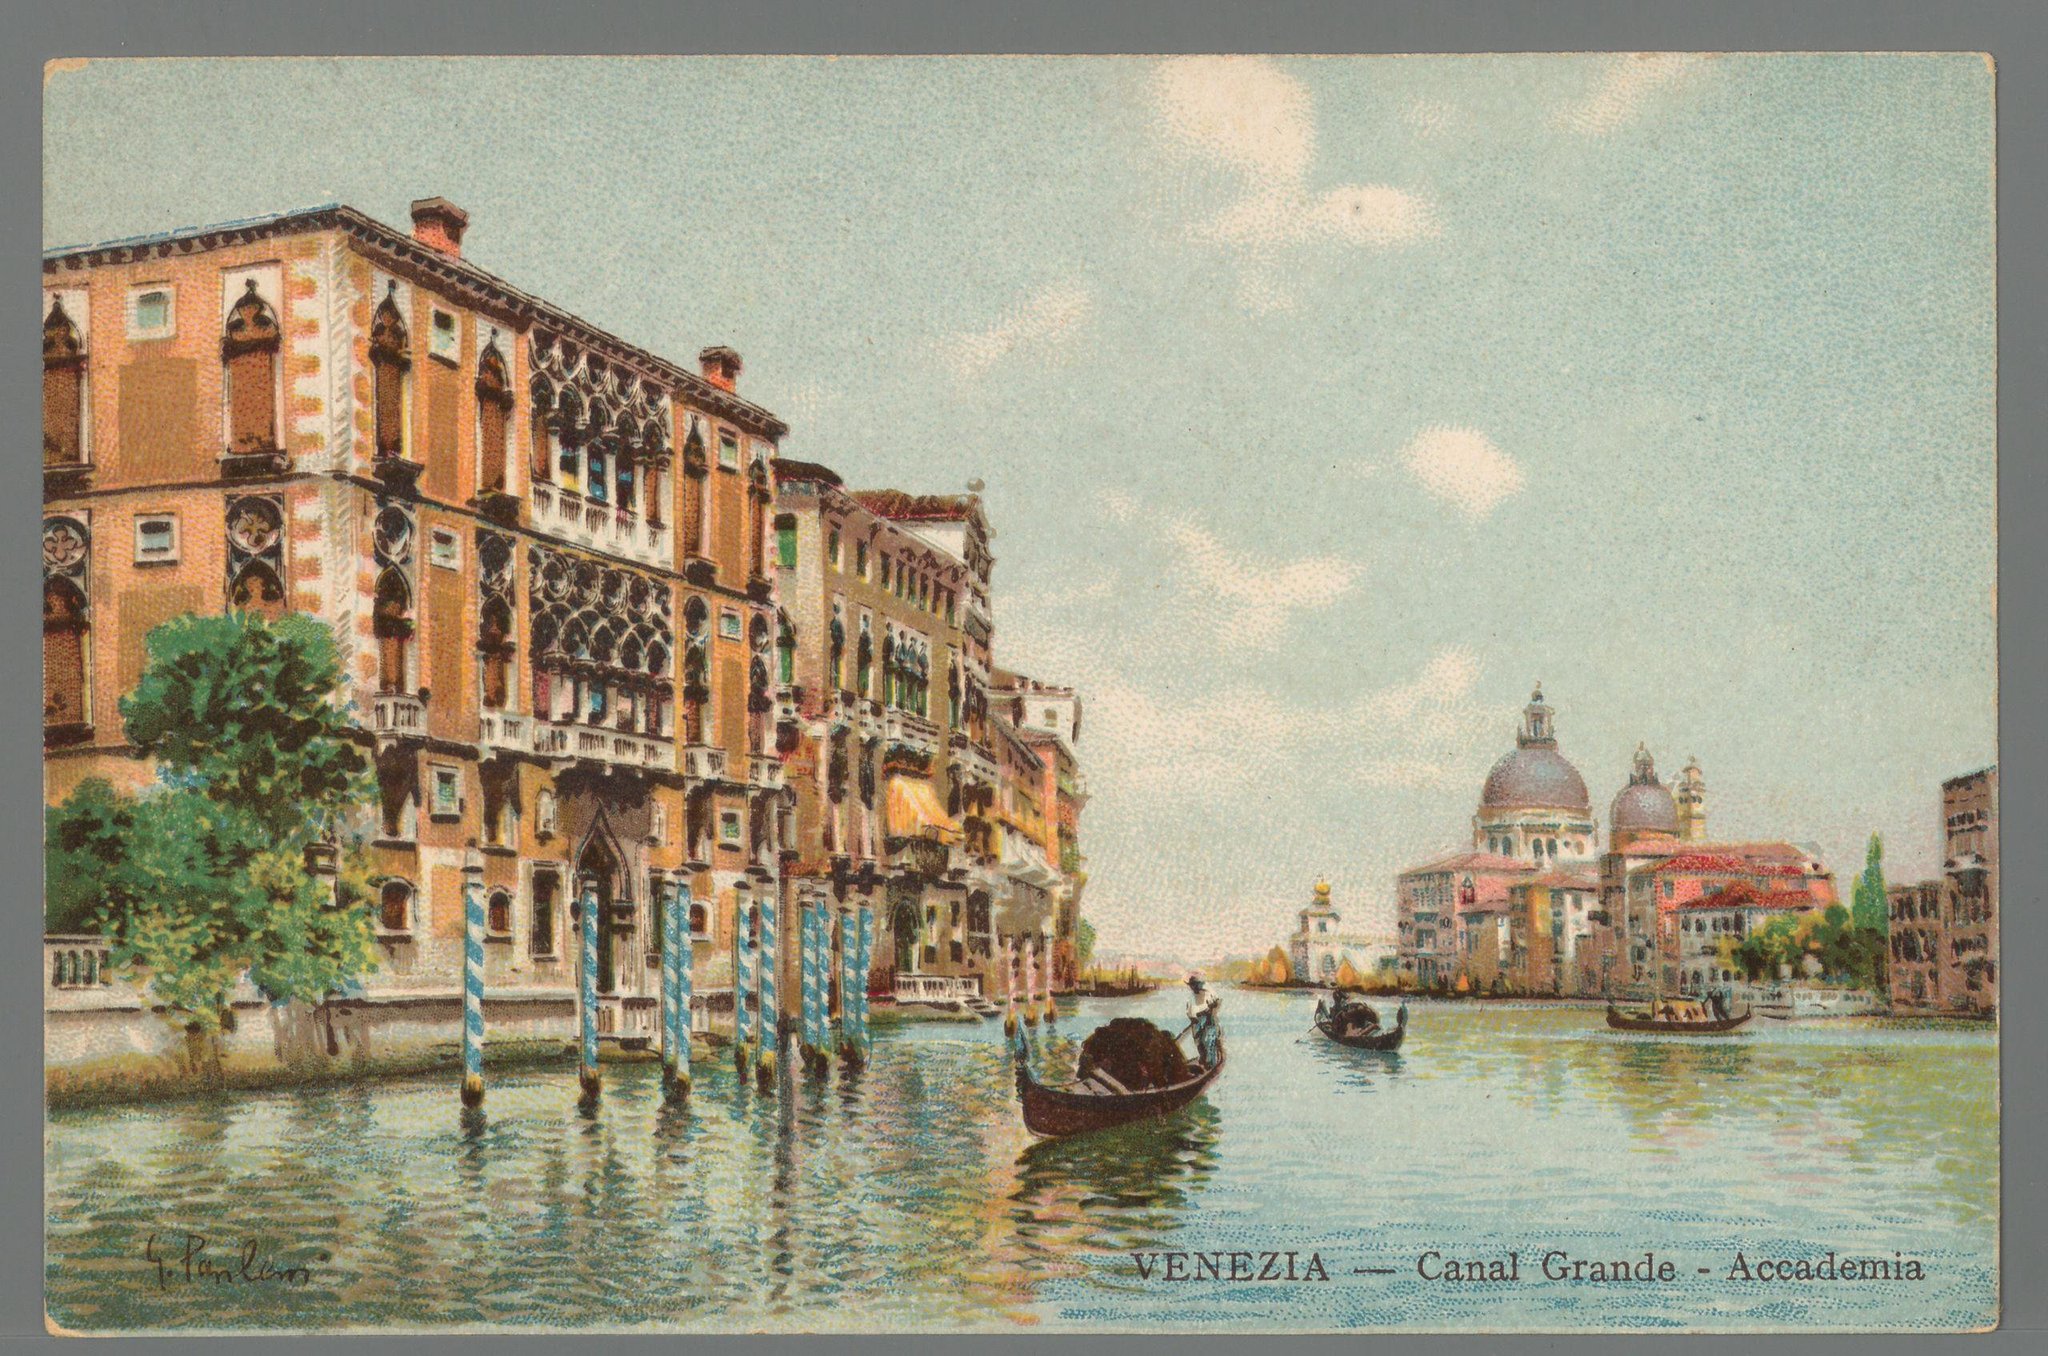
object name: reproduction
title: Venezia. Canal Grande. Accademia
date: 1905-1930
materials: cardboard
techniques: lithograph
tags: canal, church (exterior), city-view, and landscape with man-made constructions (+ city(-scape) with figures, staffage)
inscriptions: monogram: ‘E.S.’, signature: ‘G. P[...]’